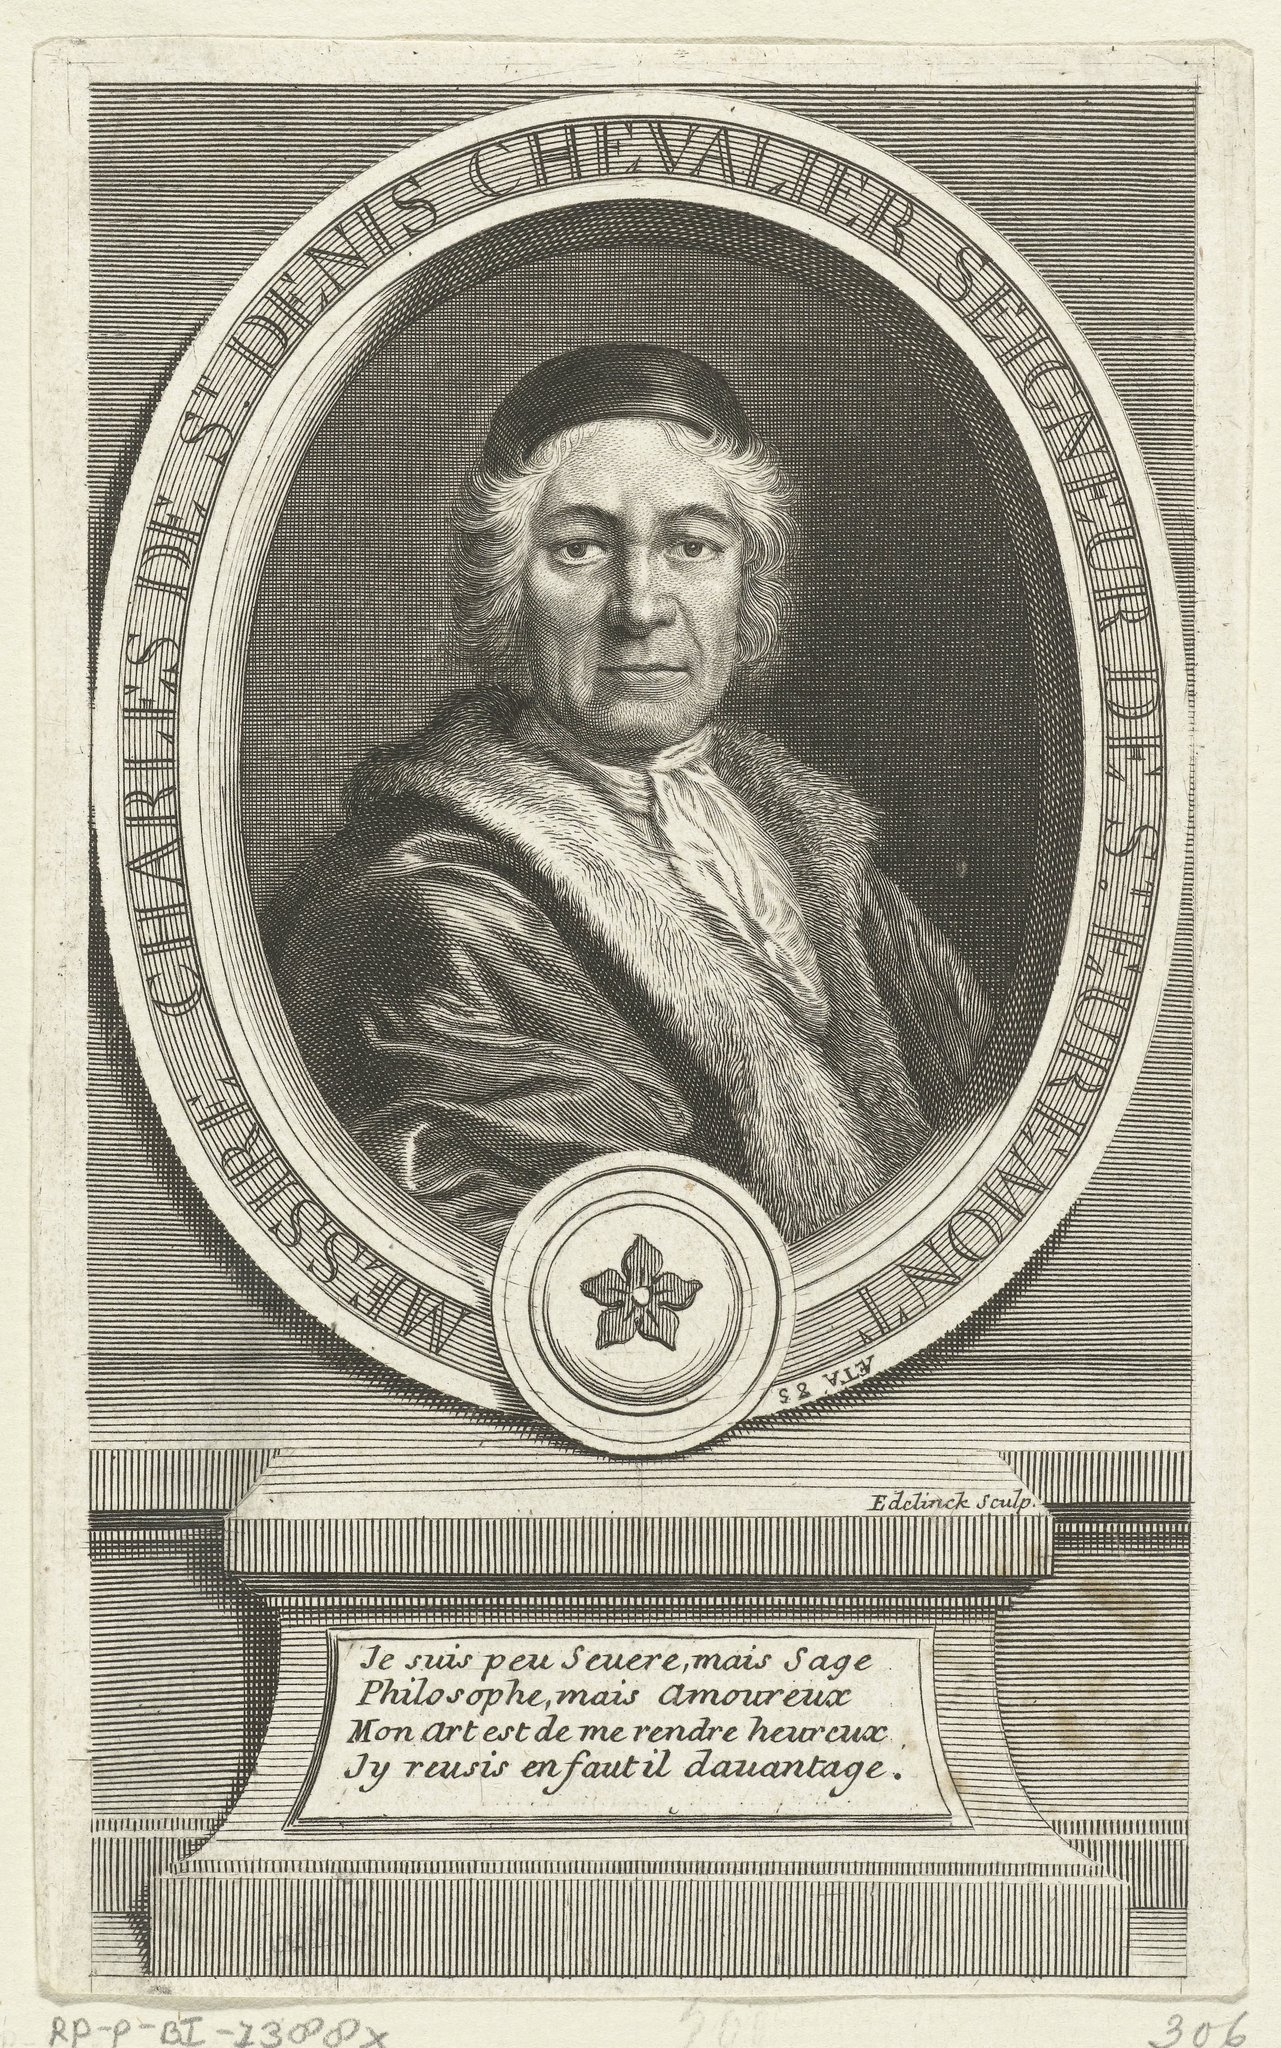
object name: print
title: Portret van Charles de Marguetel de Saint-Denis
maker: gerard edelinck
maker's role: print maker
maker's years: 1640-1707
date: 1652-1707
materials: paper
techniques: engraving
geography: france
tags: england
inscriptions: collector's mark: Lugt 240, inscription: ‘No 390. ...-...-uit De la Coierts(?) Verk. te Leyden in Apr. (?) 1767’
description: Portret van Charles de Marguetel de Saint-Denis (1610-1703), heer van Saint-Évremond, afgebeeld in ovale omlijsting met Franse tekst en cartouche met bloem. Onder de lijst een Franse tekst van vier regels.